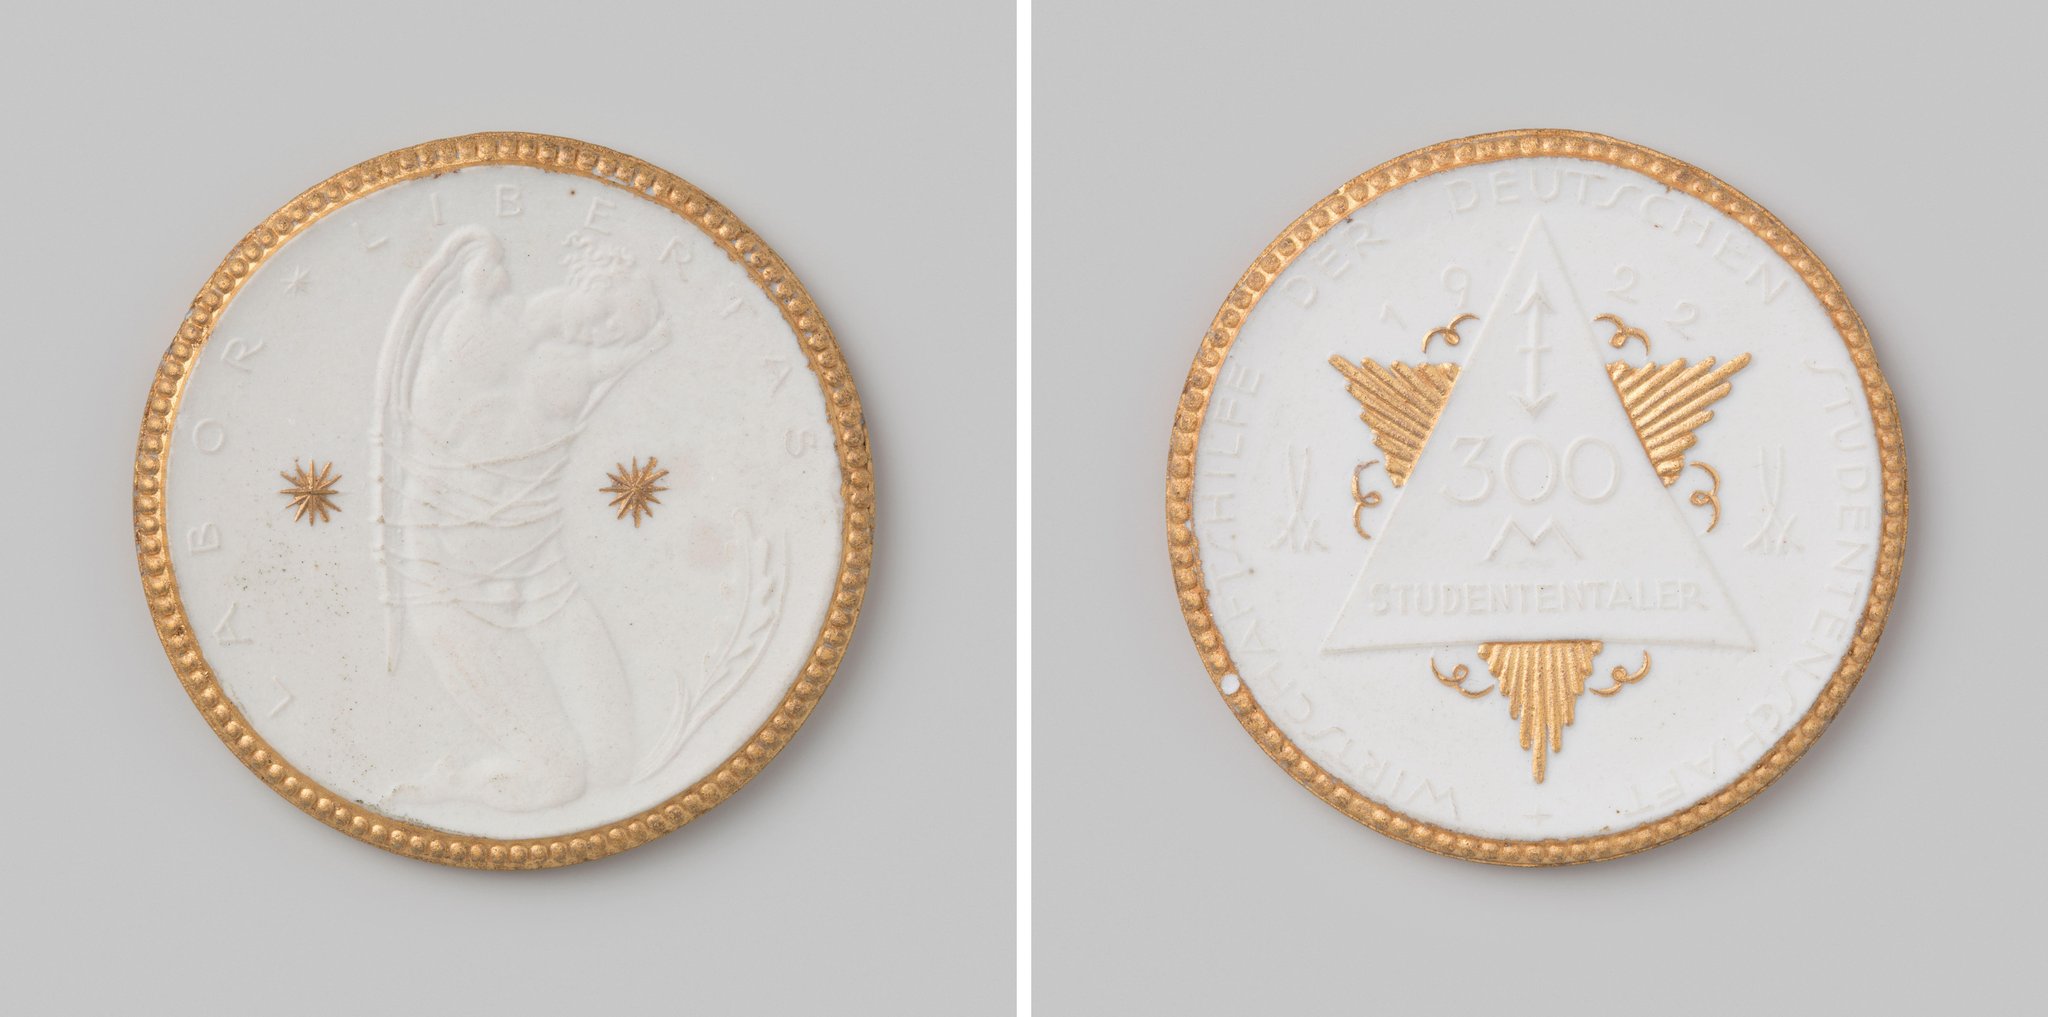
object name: coin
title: 300 mark studententaler uit Duitsland als wirtschaftshilfe der Deutschen Studentenschaft, 1922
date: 1922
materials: porcelain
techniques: casting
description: Witporseleinen pseudomunt met vergulde rand. Voorzijde: tussen twee vergulde sterren geboeide geknielde engel met rechts een tak. Keerzijde: binnen twee driehoeken, waarvan één verguld, waarde-aanduiding in drie regels. Daarboven jaartal. Kartelrand.